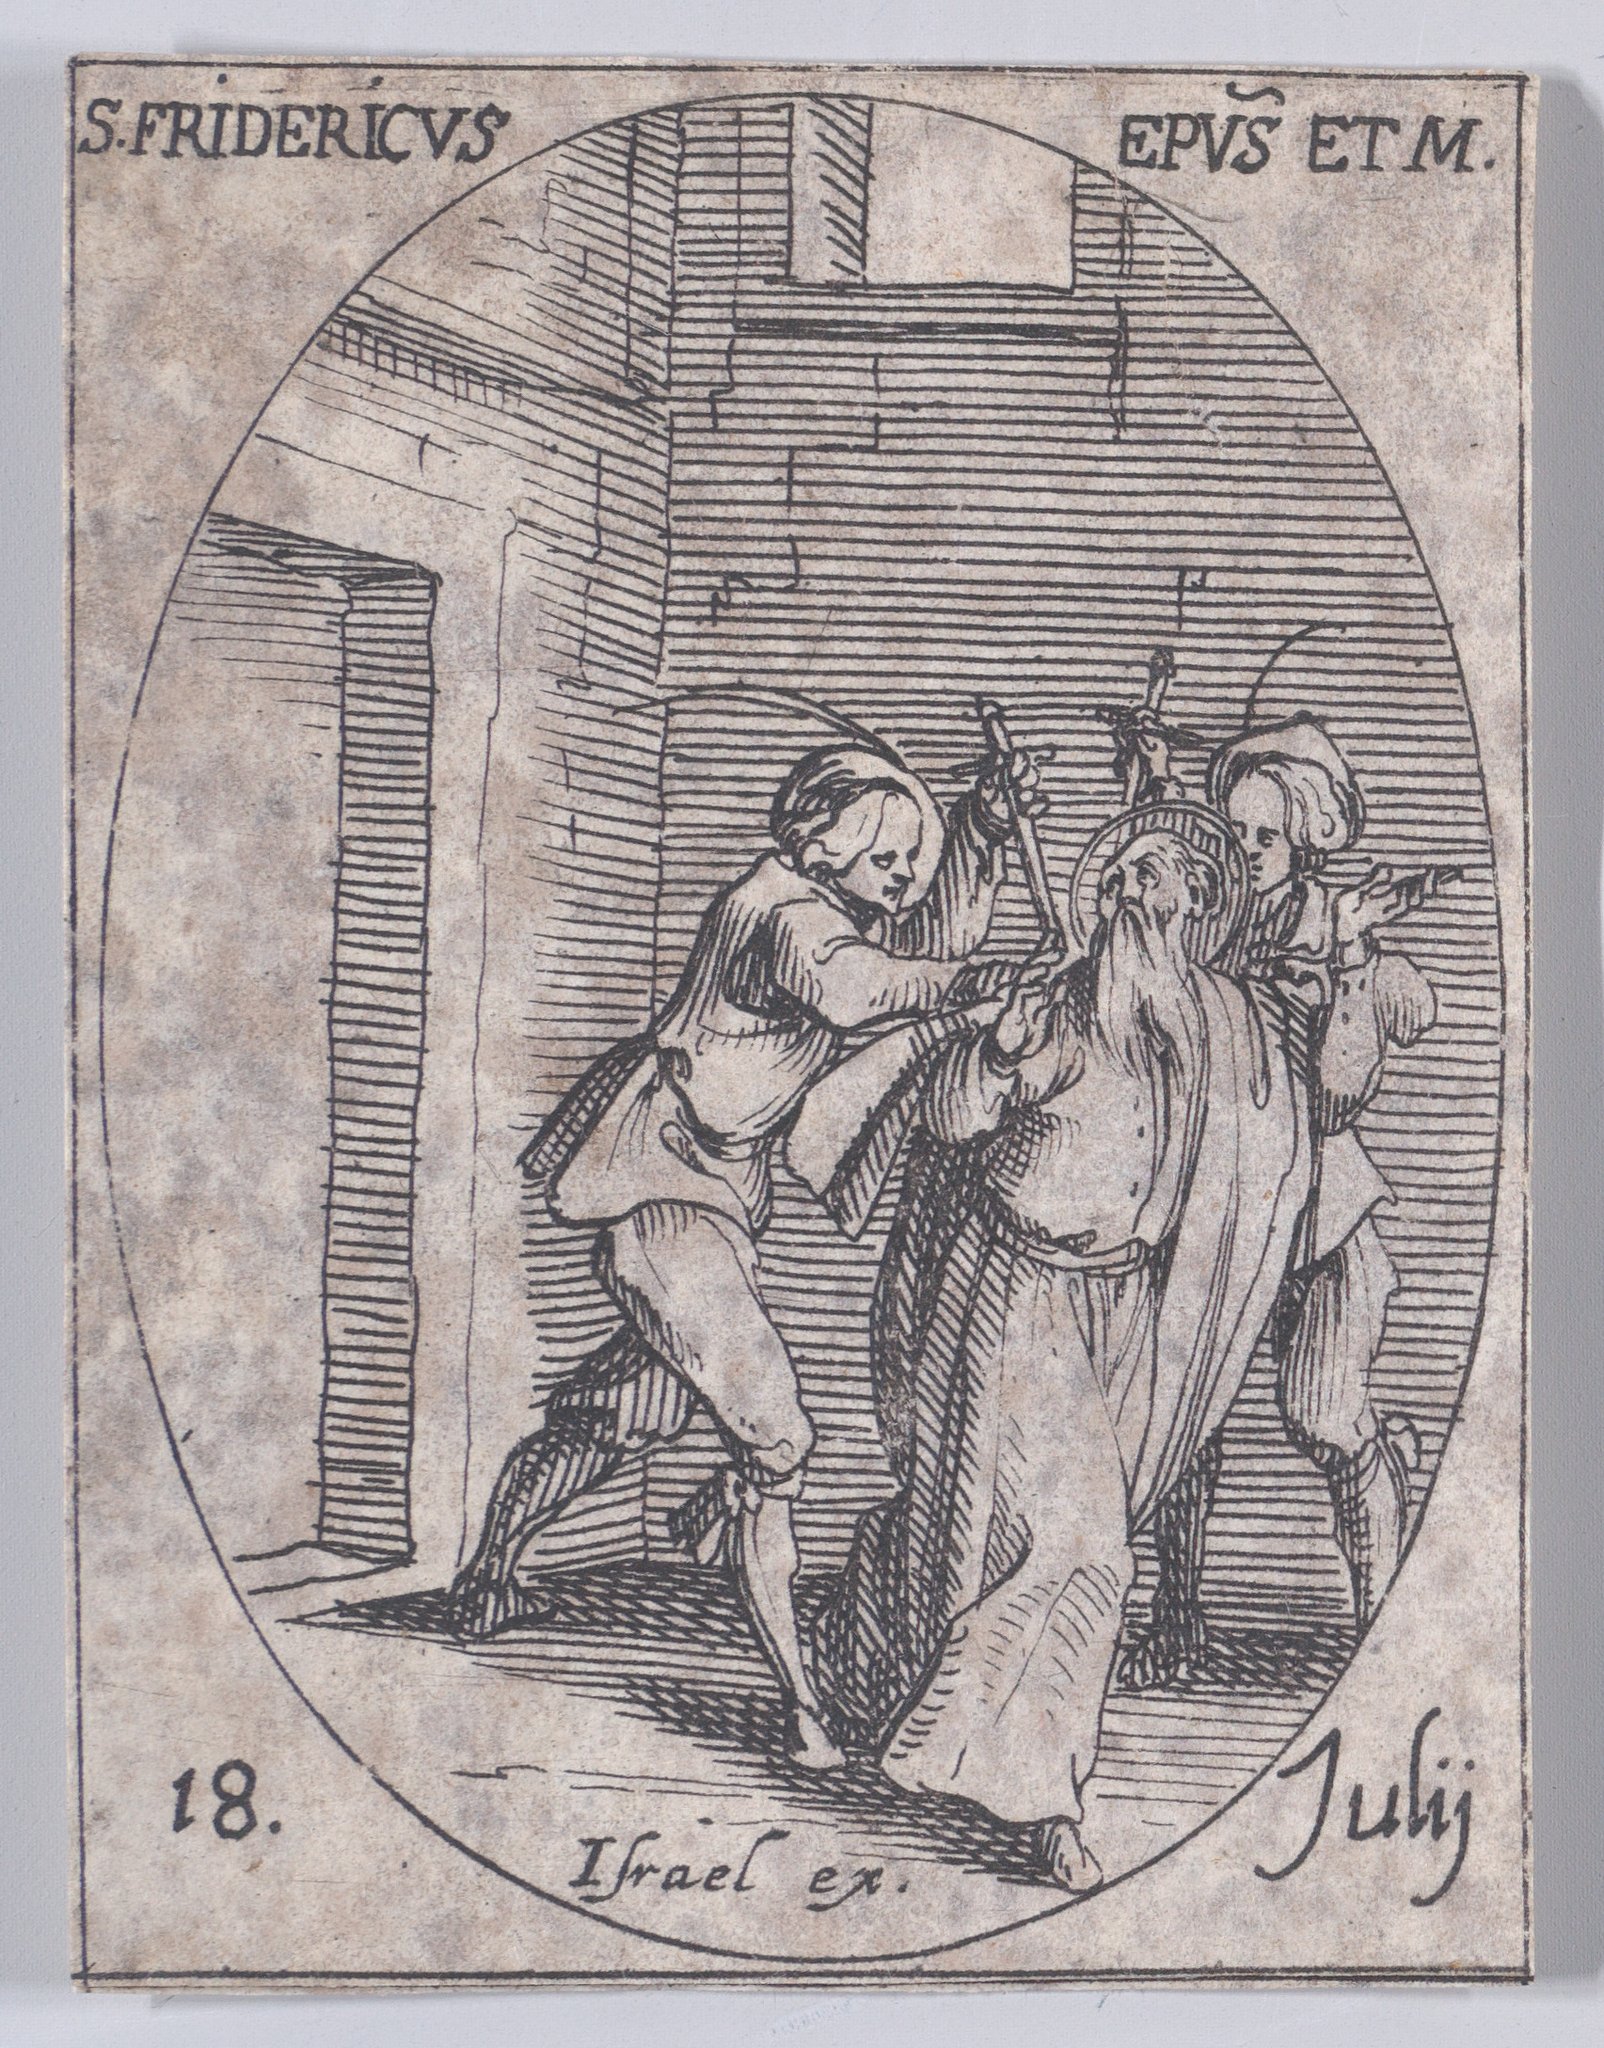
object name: print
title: S. Frédéric, évêque et martyr (St. Frederick, Bishop and Martyr), July 18th, from "Les Images De Tous Les Saincts et Saintes de L'Année" (Images of All of the Saints and Religious Events of the Year)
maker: jacques callot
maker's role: artist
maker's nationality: french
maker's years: 1592-1635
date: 1636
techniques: etching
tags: men,saints